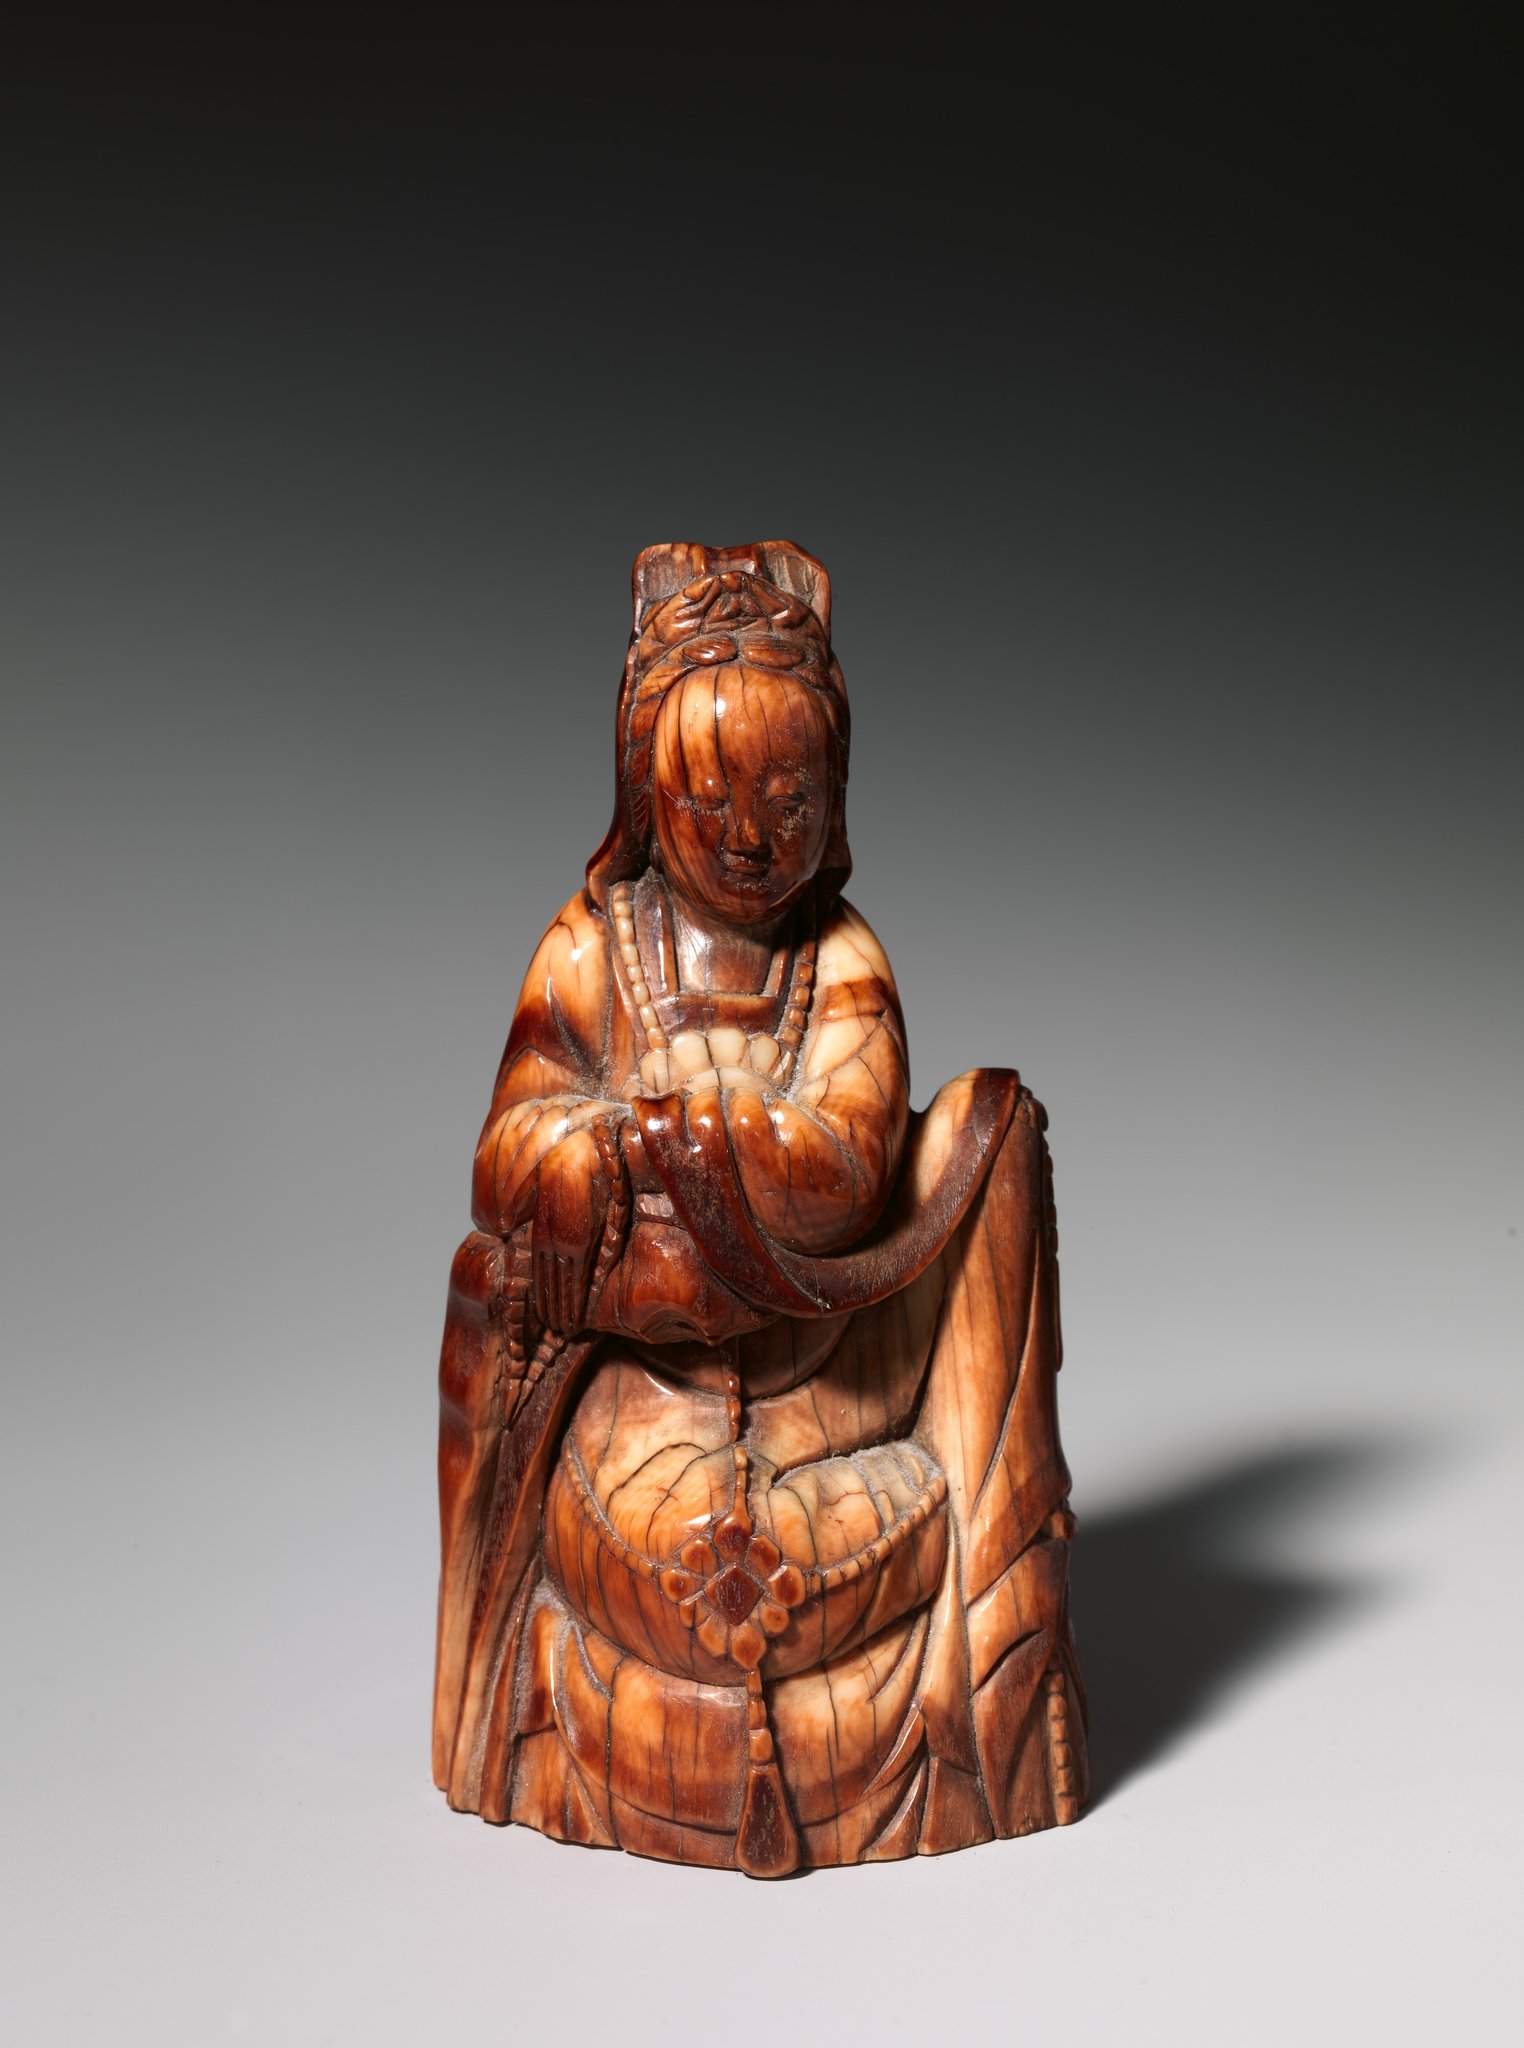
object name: figurine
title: Guanyin, the Bodhisattva of Compassion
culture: chinese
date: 1667-1733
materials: ivory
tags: buddhism,bodhisattvas